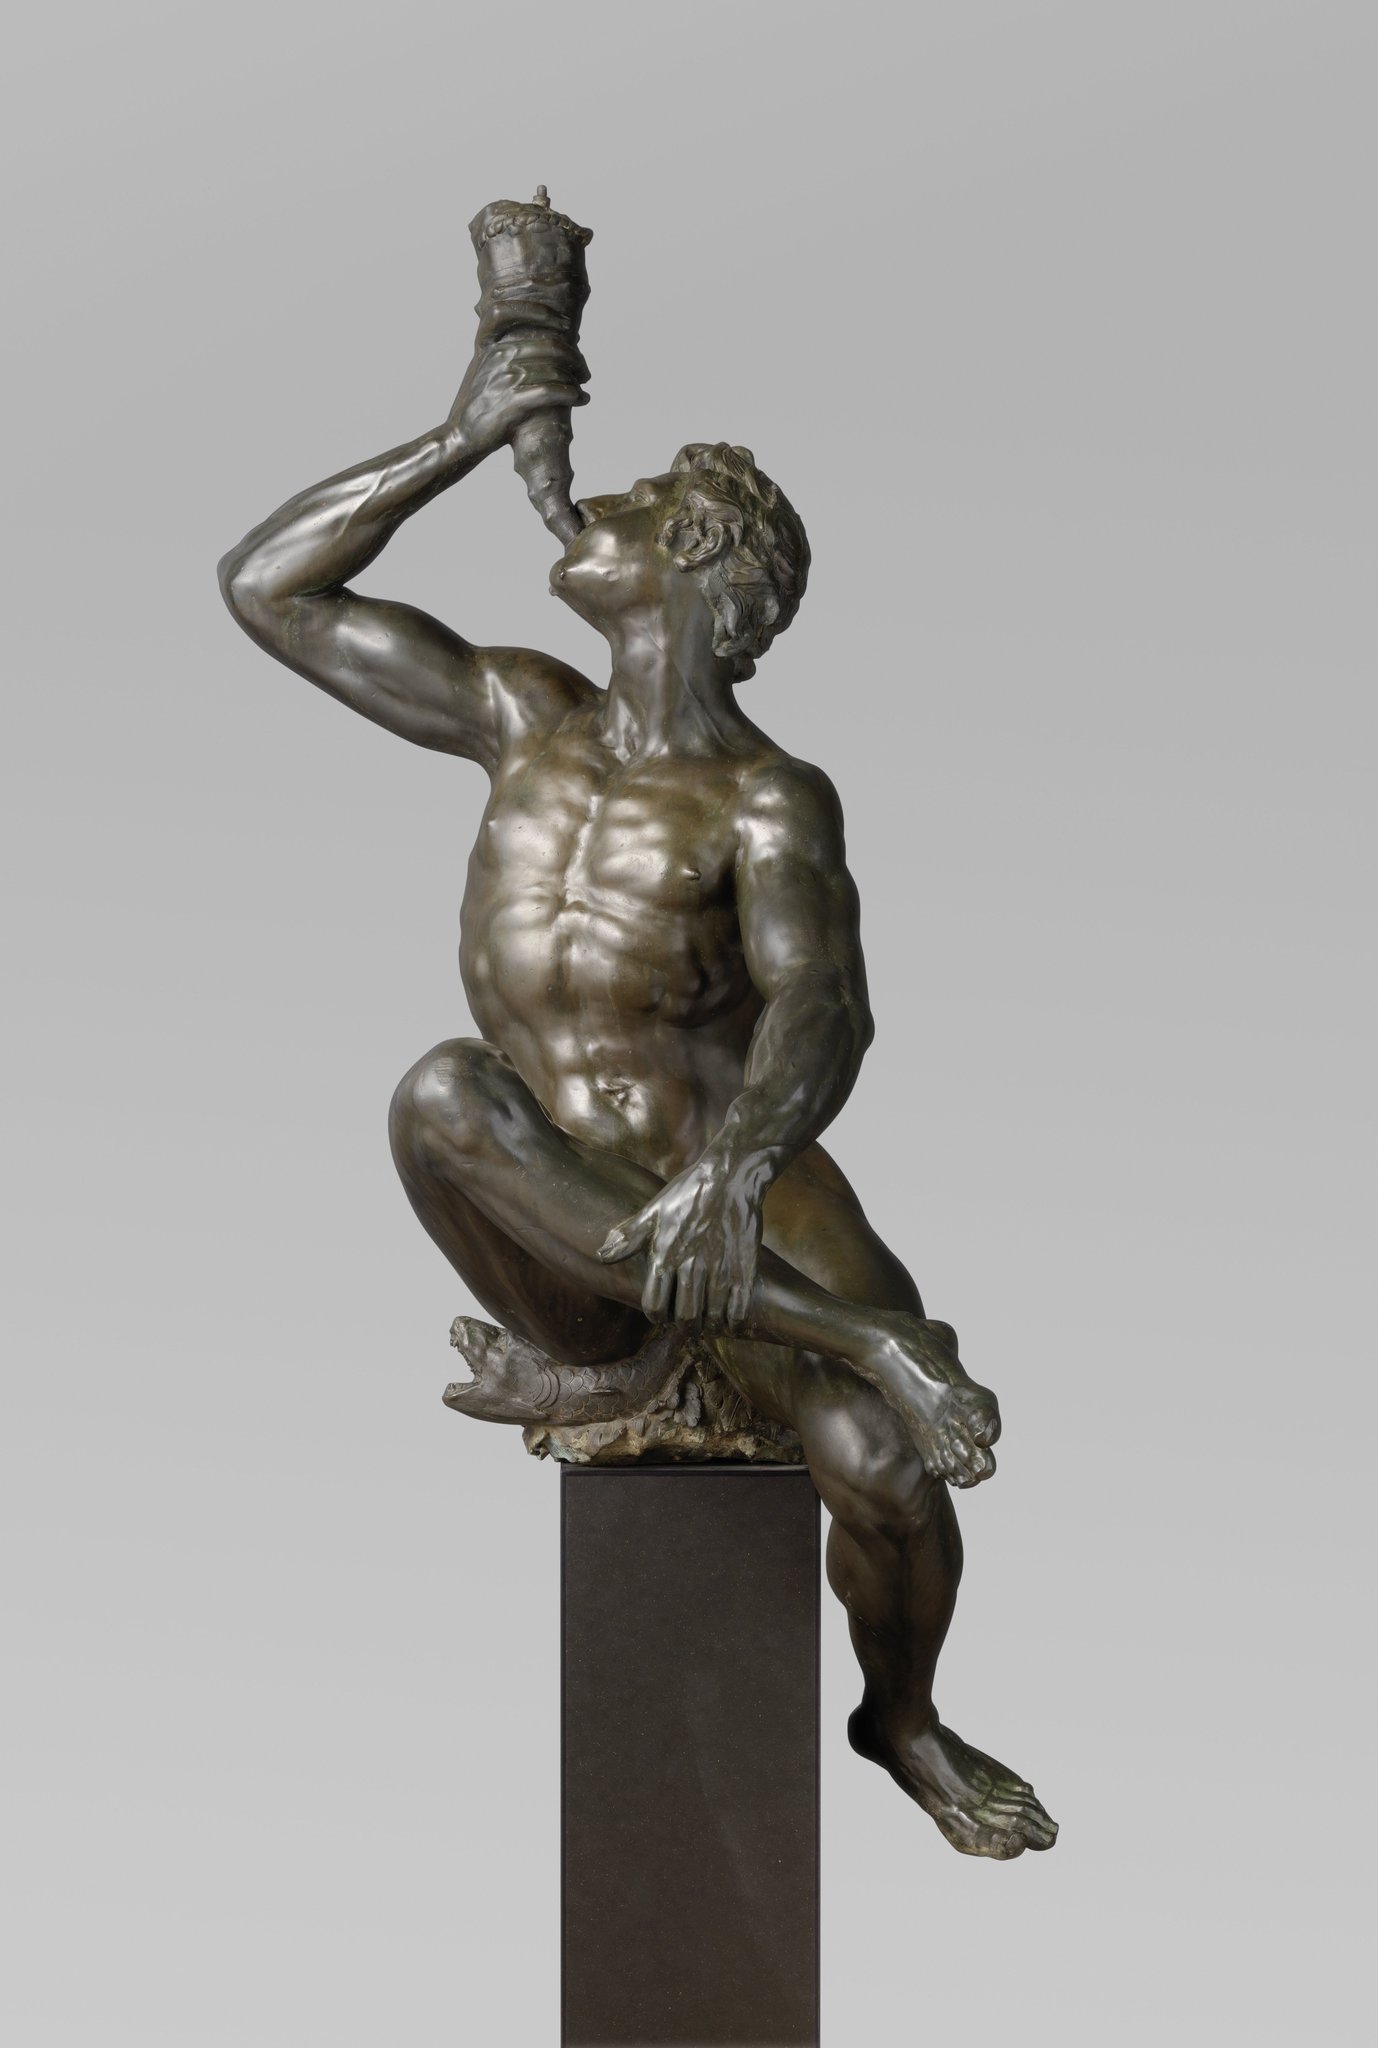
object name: figure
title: Triton, Blowing on a Trumpet Shell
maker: adriaen de vries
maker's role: draughtsman, sculptor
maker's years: 1556-1626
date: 1615-1617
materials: bronze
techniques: casting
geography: prague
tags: triton(s) (+ attributes)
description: This triton, a sea creature in the retinue of the god Neptune, is one of sixteen sculptures that together once formed part of a monumental fountain. The huge complex stood in front of Frederiksborg Castle in Denmark, but in 1659 Swedish soldiers took the statues as war booty to Stockholm. The triton originally perched on the edge of a basin, and water spouted from the shell he is blowing.